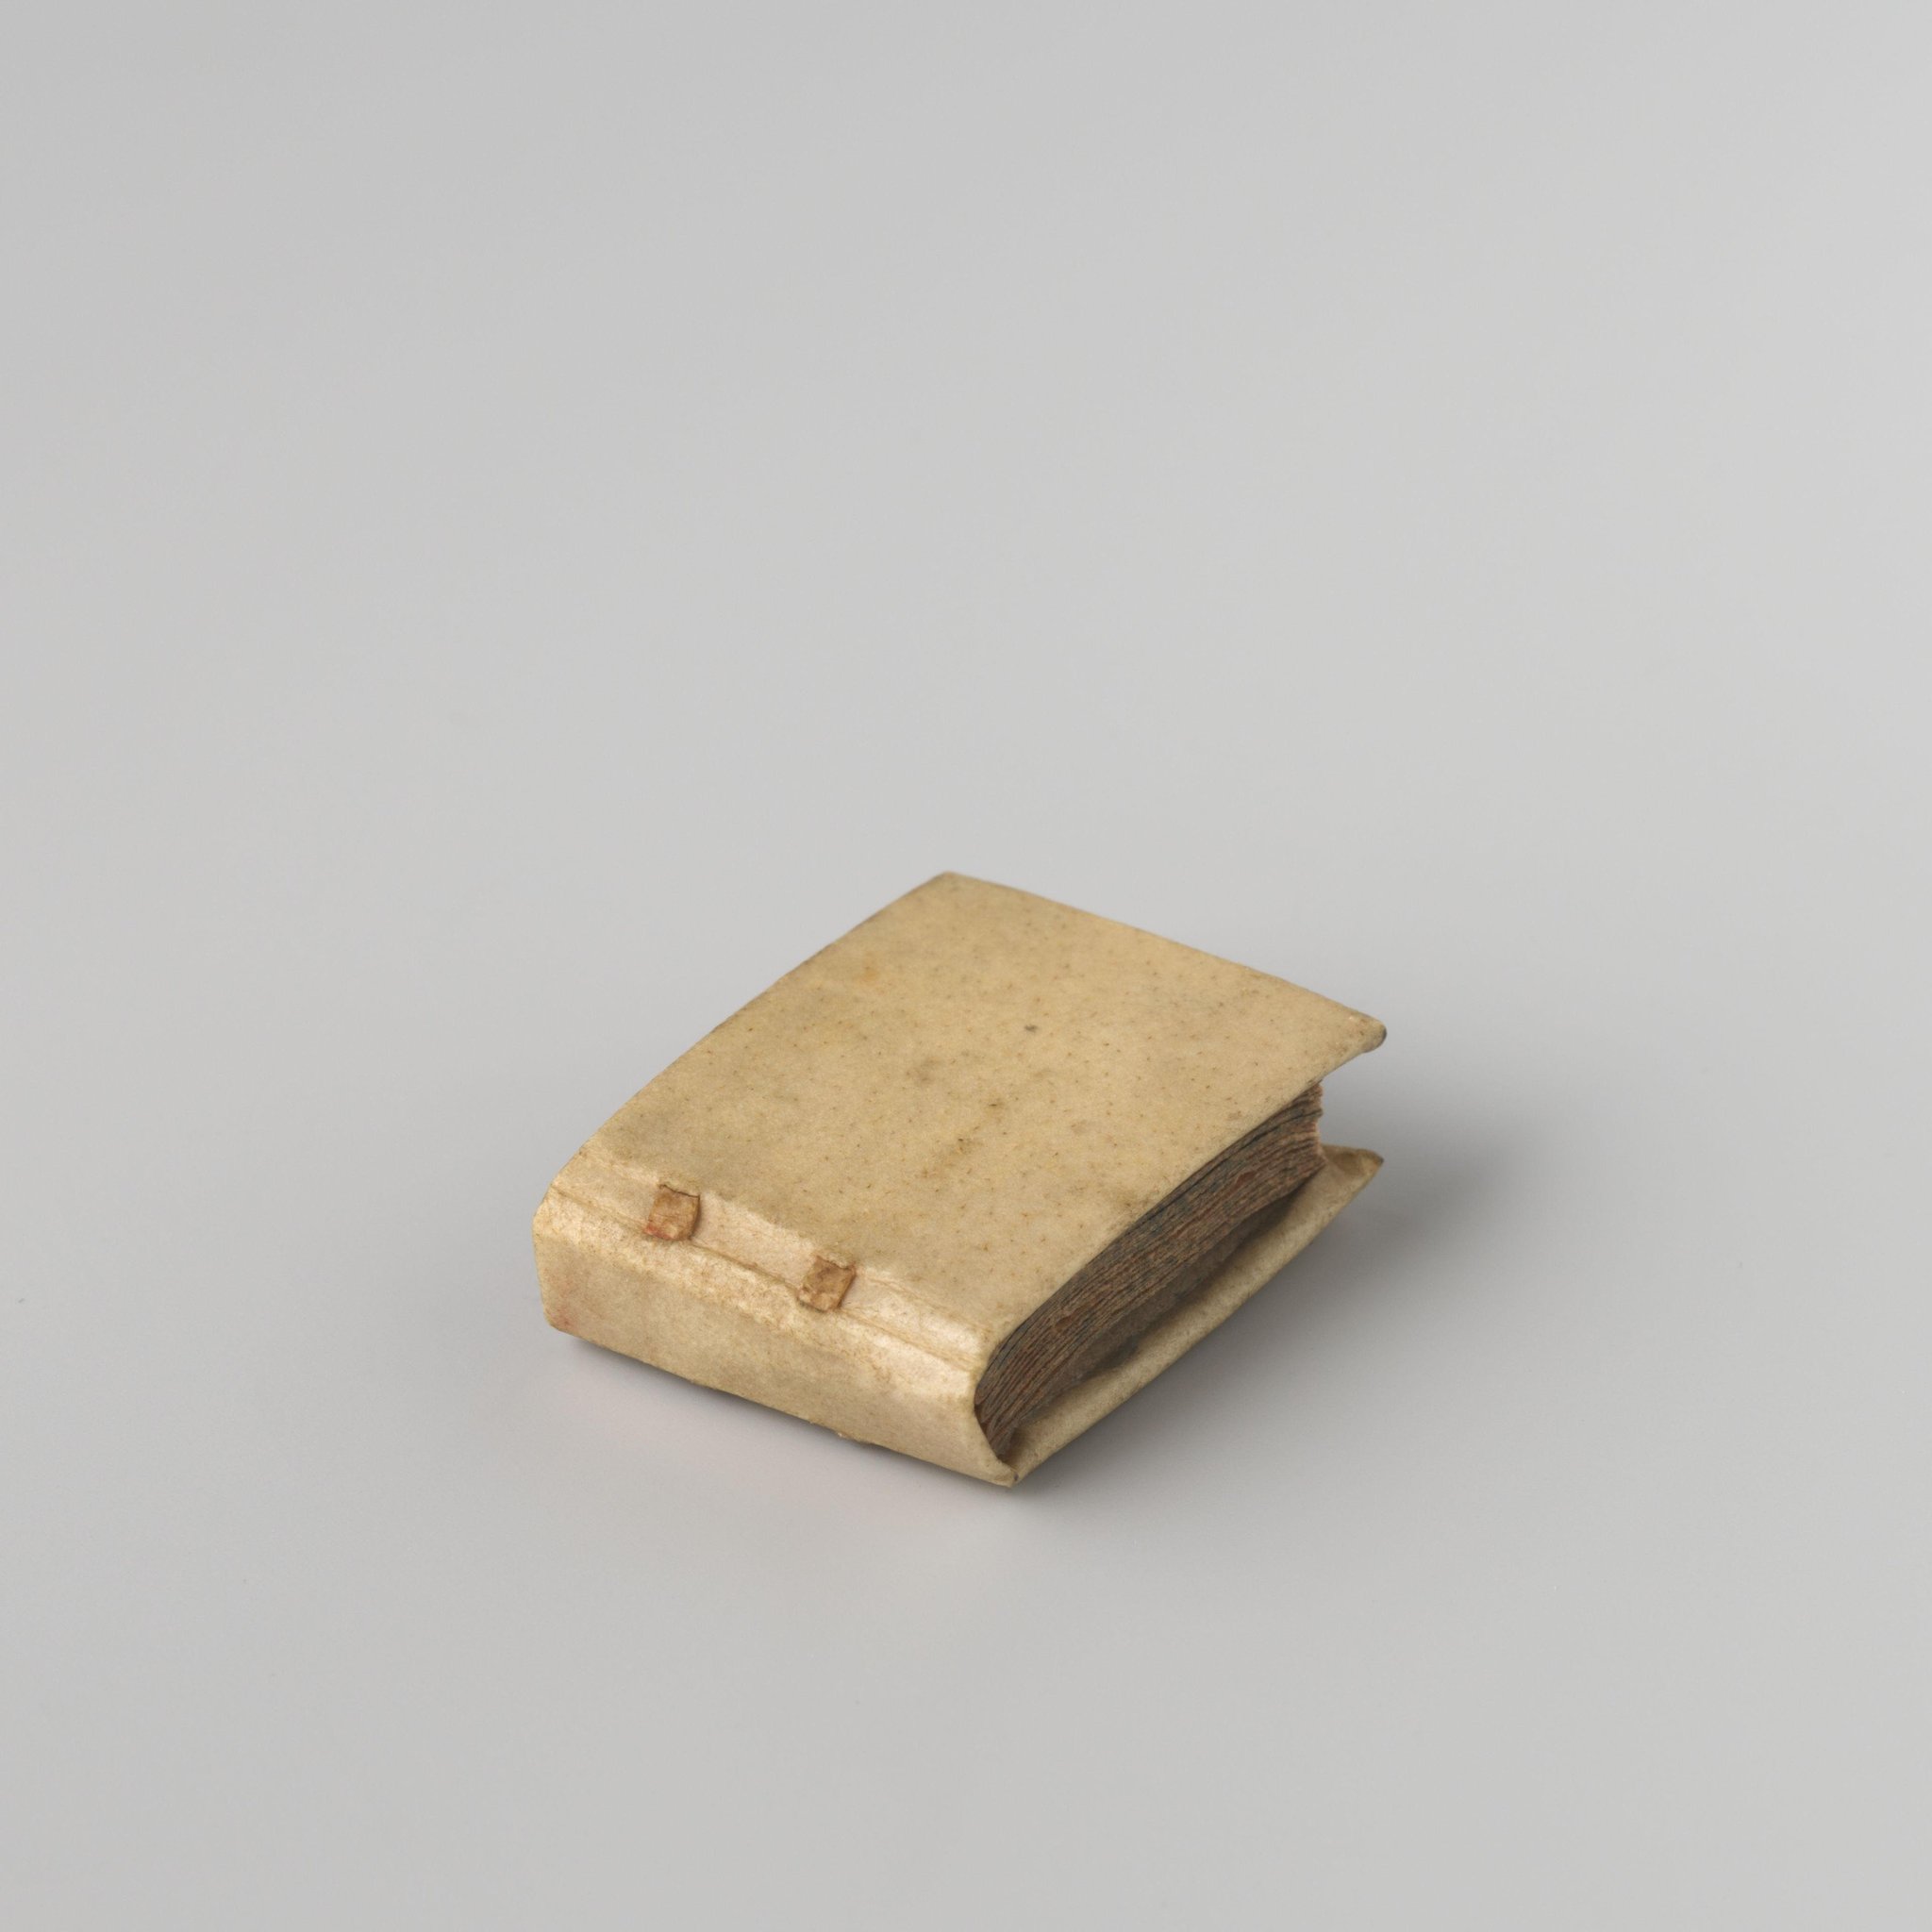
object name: book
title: Boek met tuingezichten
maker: Anonymous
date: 1690-1710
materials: paper, parchment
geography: amsterdam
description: Boek met tuingezichten. Ingebonden in blank perkament.